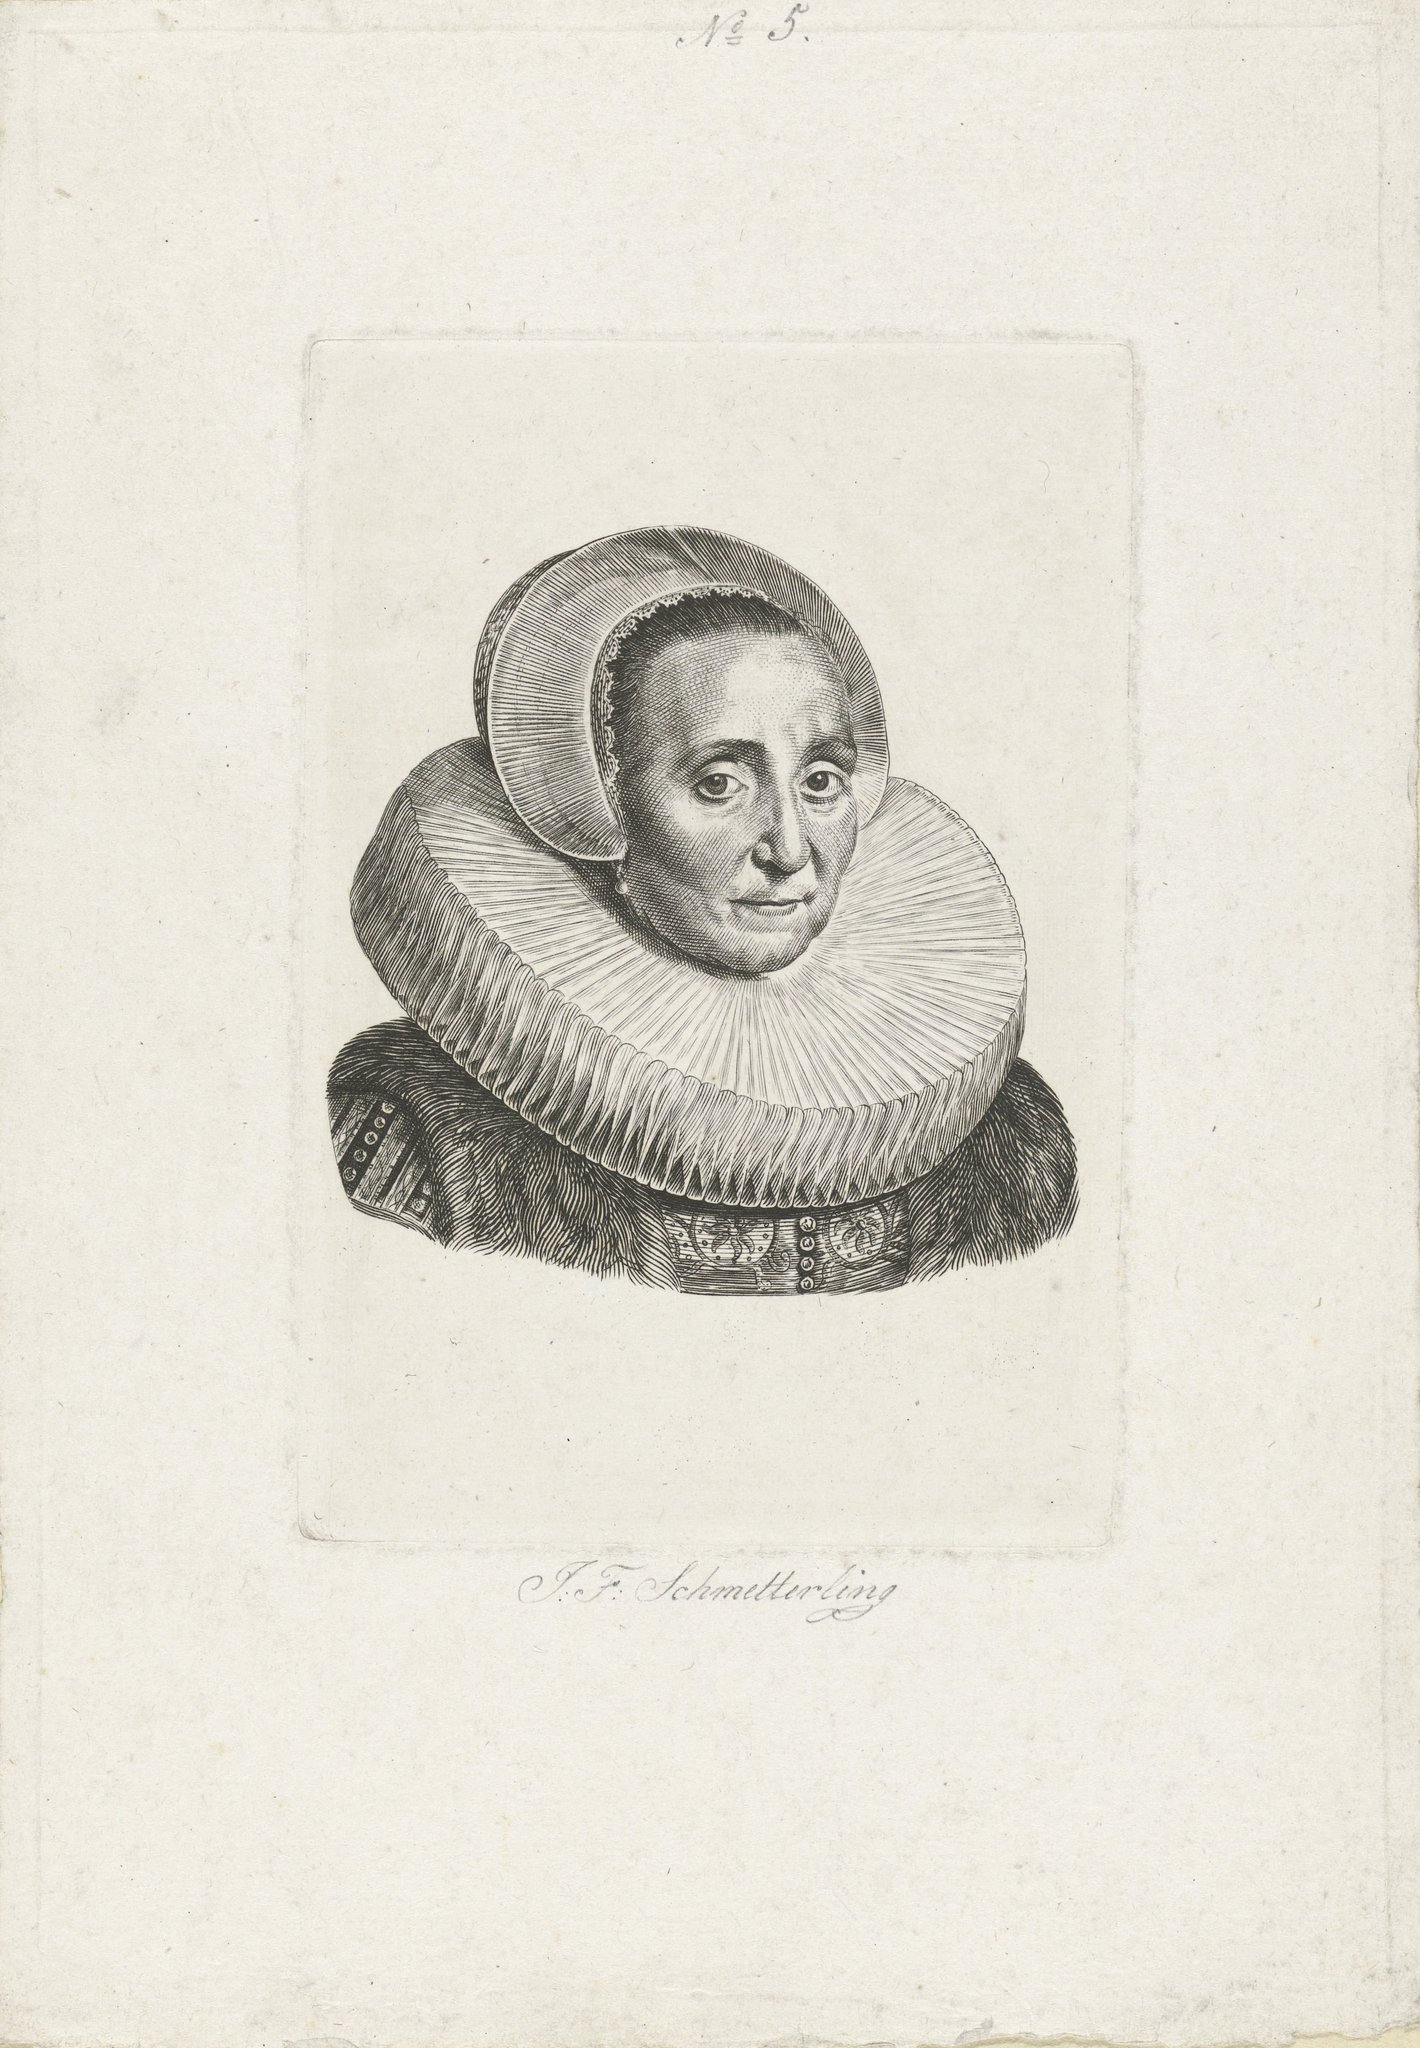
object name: print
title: Portret van een vrouw met stijve plooikraag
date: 1825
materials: paper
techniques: engraving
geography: netherlands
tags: adult woman, head-gear: cap (+ women's clothes), neck-gear ~ clothing (with name) (+ women's clothes)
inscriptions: inscription: ‘Ge Graveert naar W: Delft / 1825’, inscription: ‘N5 J:F: Schmetterling’